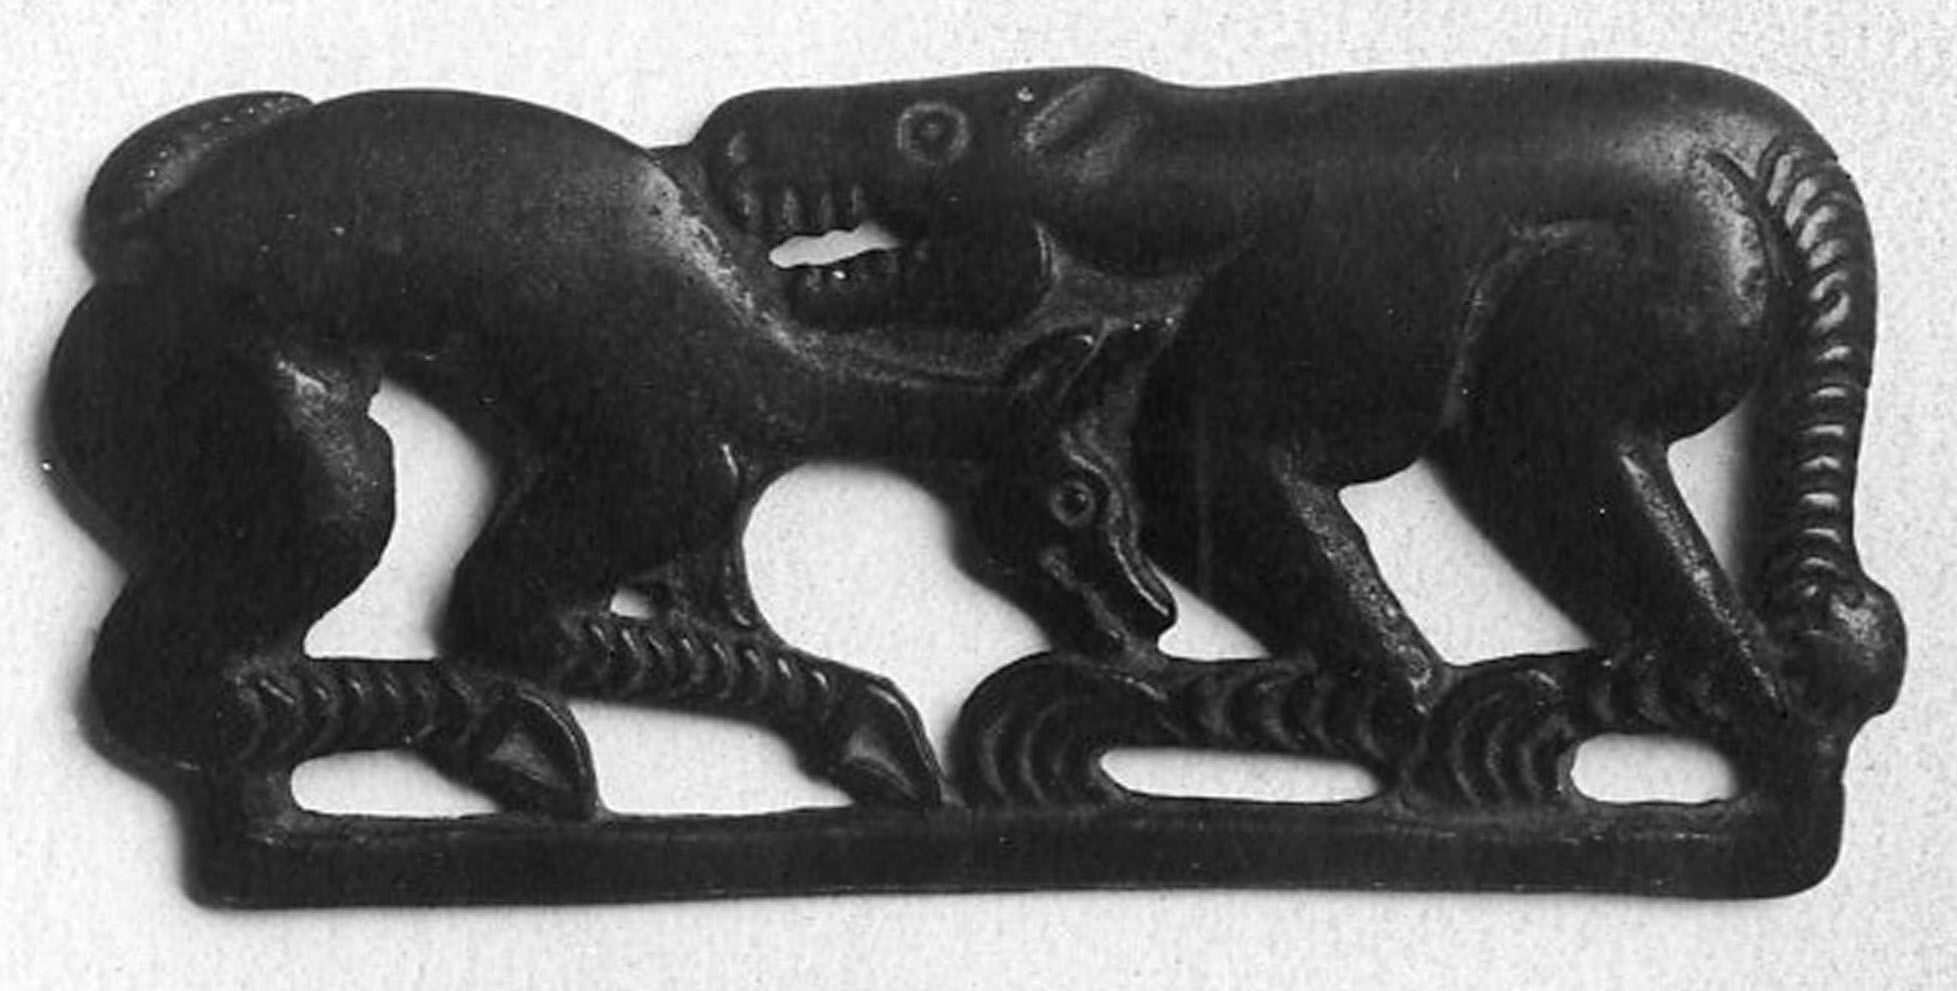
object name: plaque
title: Openwork Plaque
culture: chinese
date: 206 BCE-220 CE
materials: bronze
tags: animals